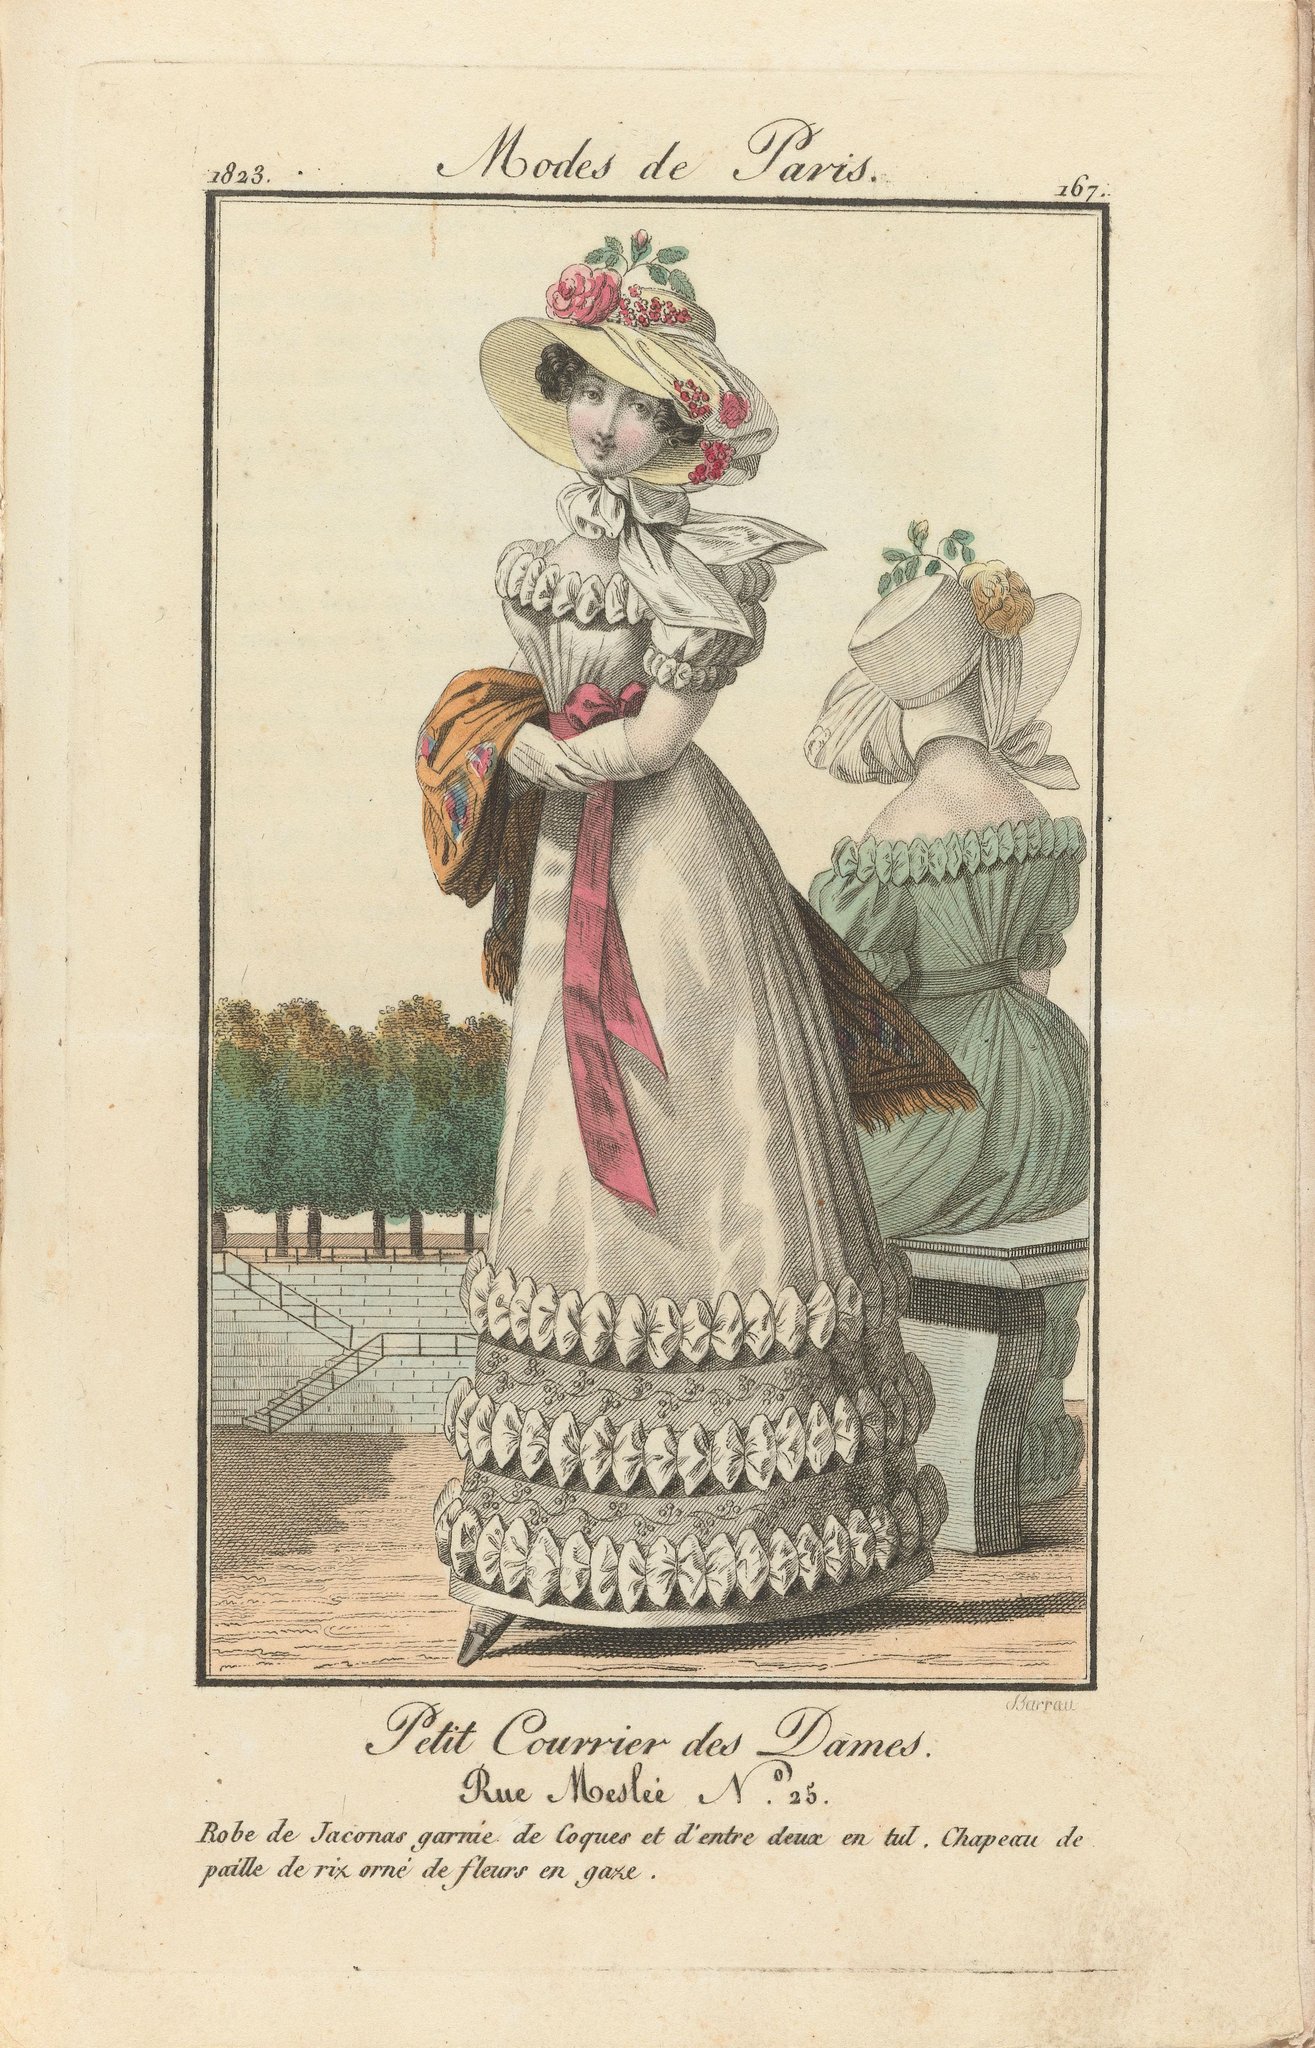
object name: fashion print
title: Petit Courrier des Dames 1823 (167)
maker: jean-charles-michel barreau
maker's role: print maker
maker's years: 1789-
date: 1823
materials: paper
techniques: engraving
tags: fashion plates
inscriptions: date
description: Prent uit het modetijdschrift Petit Courrier des Dames (1821-1868).